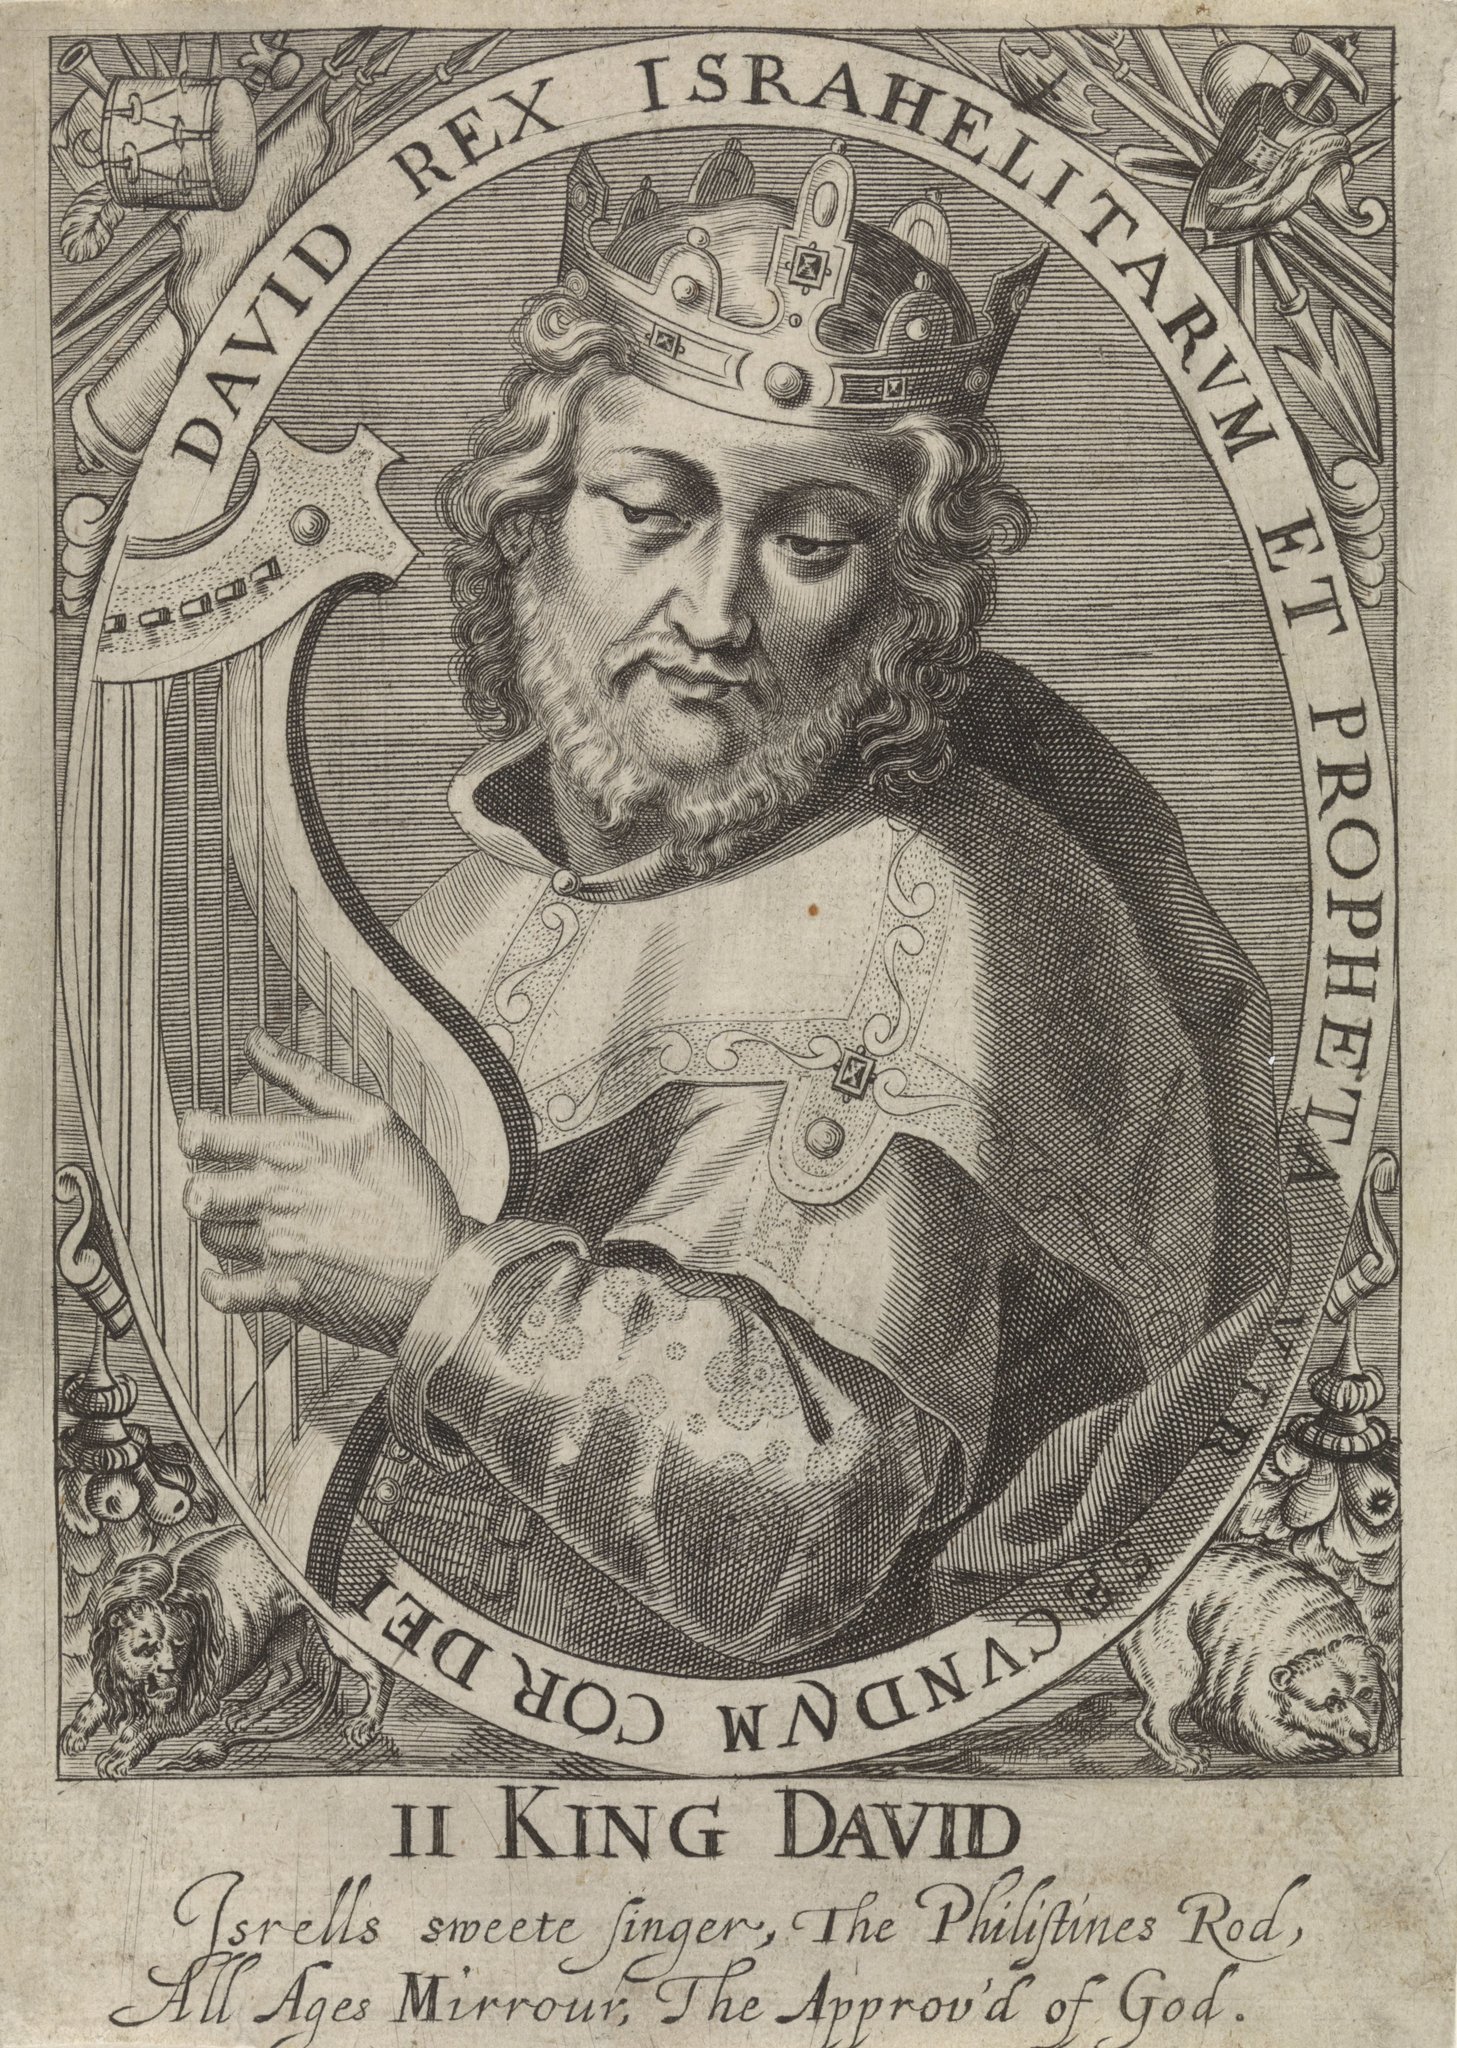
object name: print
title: De negen helden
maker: willem van de passe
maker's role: print maker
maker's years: 1597-1637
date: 1621-1636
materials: paper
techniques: engraving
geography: london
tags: david (one of the nine worthies)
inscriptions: collector's mark: Lugt 2228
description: De Joodse held David, spelend op zijn harp. Buste gevat in een ovale omlijsting met een randschrift in het Latijn. In de marge zijn naam en een tweeregelig lofdicht in het Engels.